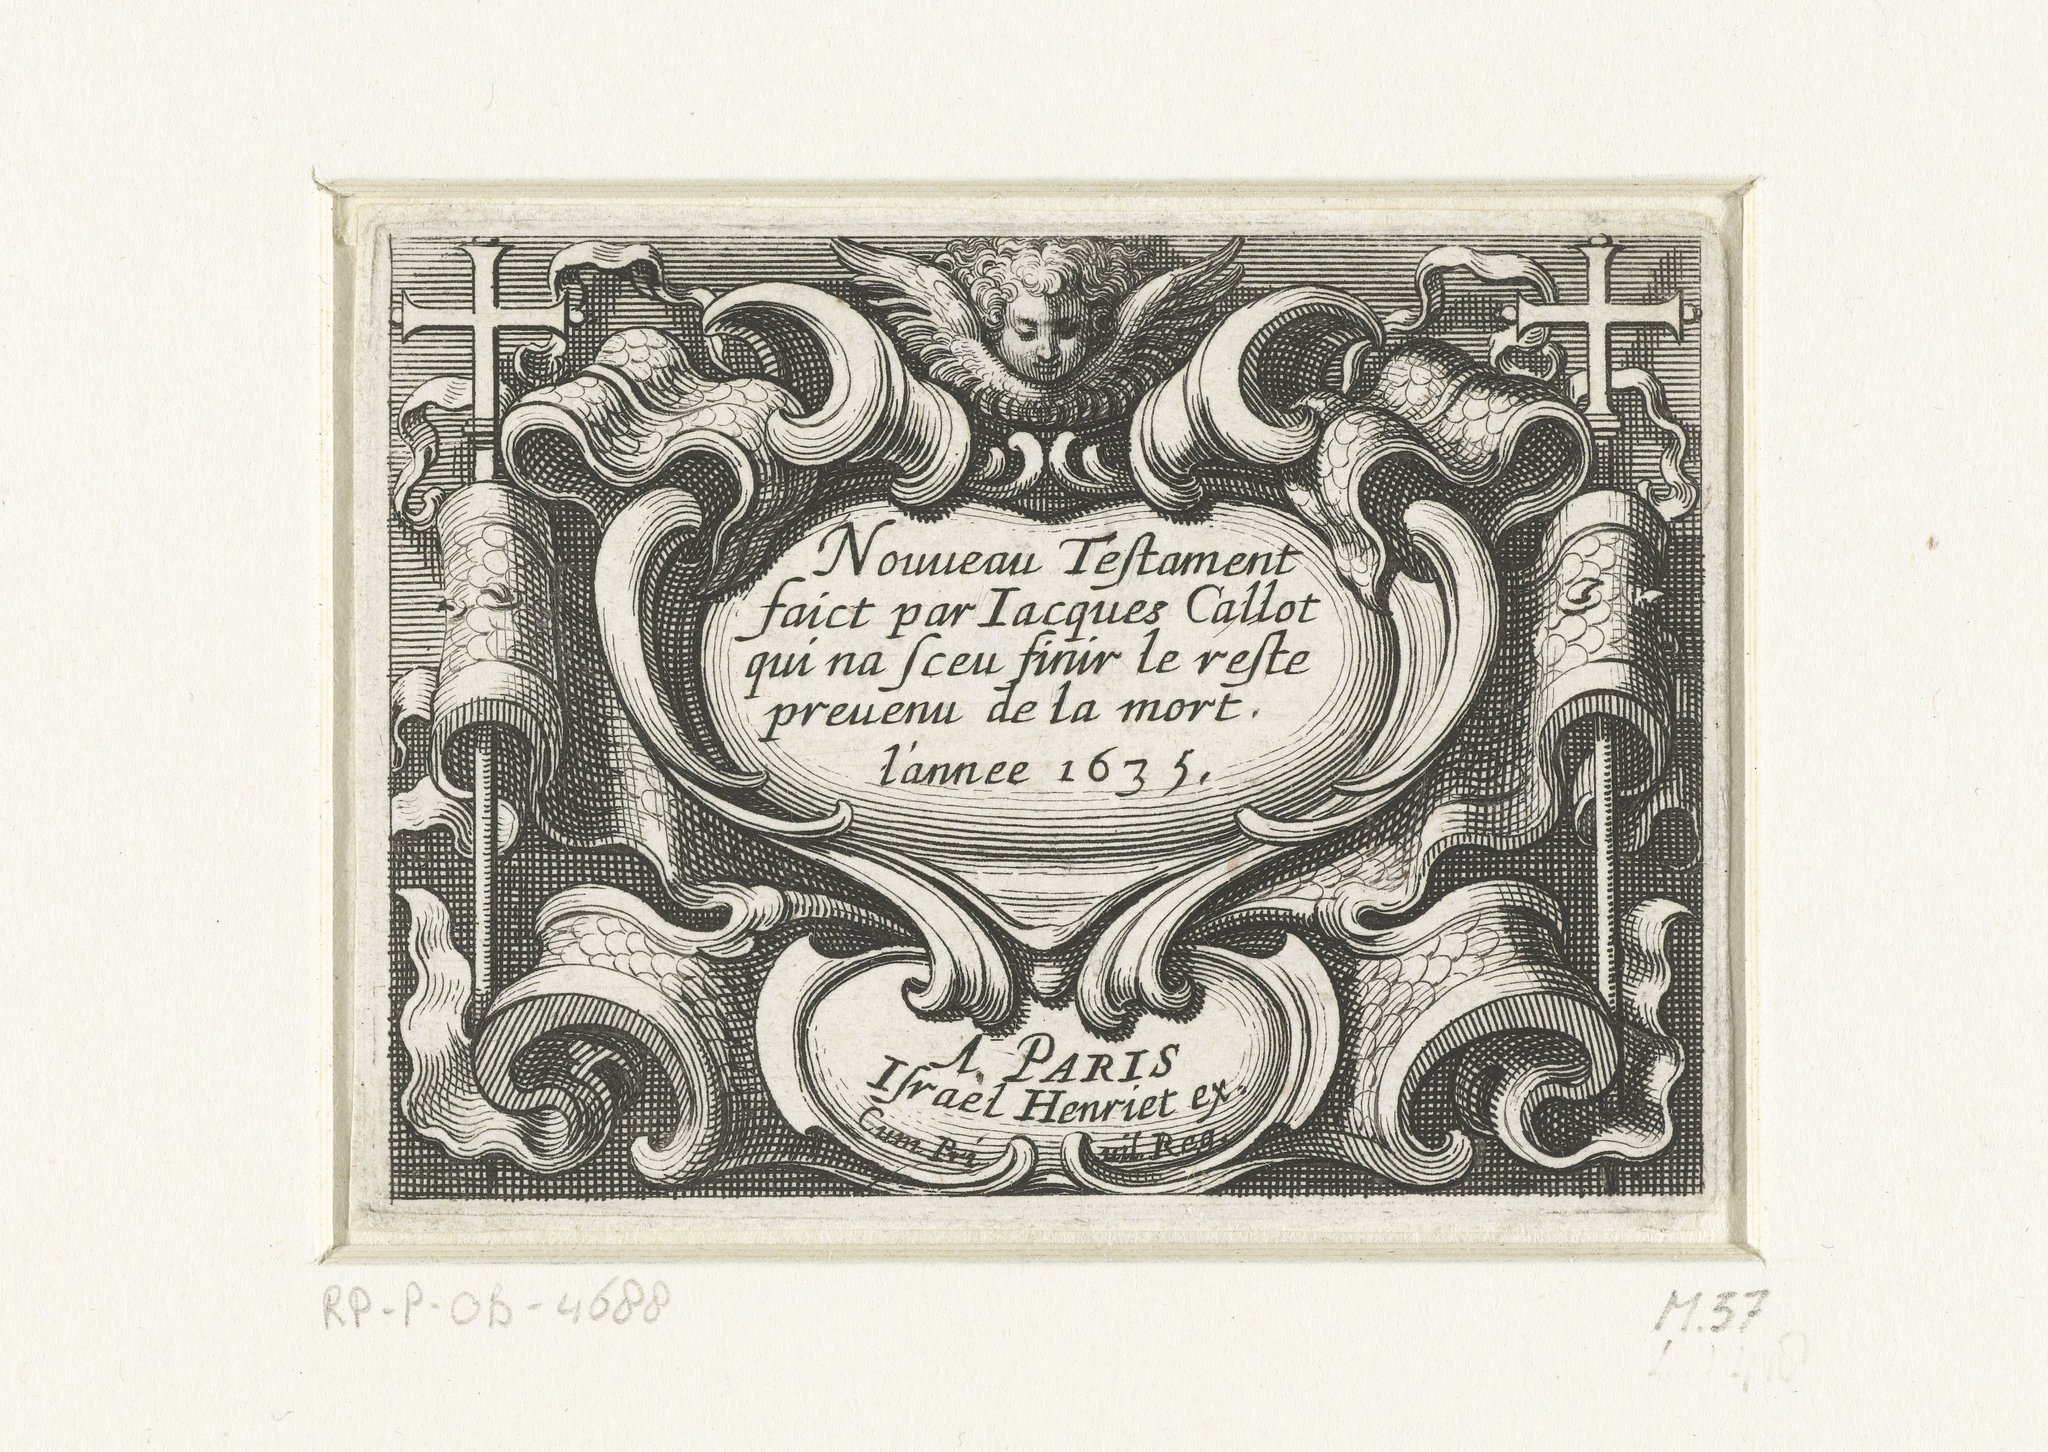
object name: titelprent, frontispice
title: Titelprent voor reeks scènes uit het Nieuwe Testament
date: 1635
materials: paper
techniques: etching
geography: paris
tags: sceptre, staff (symbol of sovereignty), title-page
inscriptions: collector's mark: Lugt 240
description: De tekst 'Nouveau Testament faict par Jacques Callot qui na sceu finir le reste prevenu de la mort. l'annee 1635.' en het adres van de uitgever in cartouches, geflankeerd door kruisstaven en bekroond door een engeltje. Deze prent is het titelblad voor een reeks van tien prenten met voorstellingen uit het Nieuwe Testament.